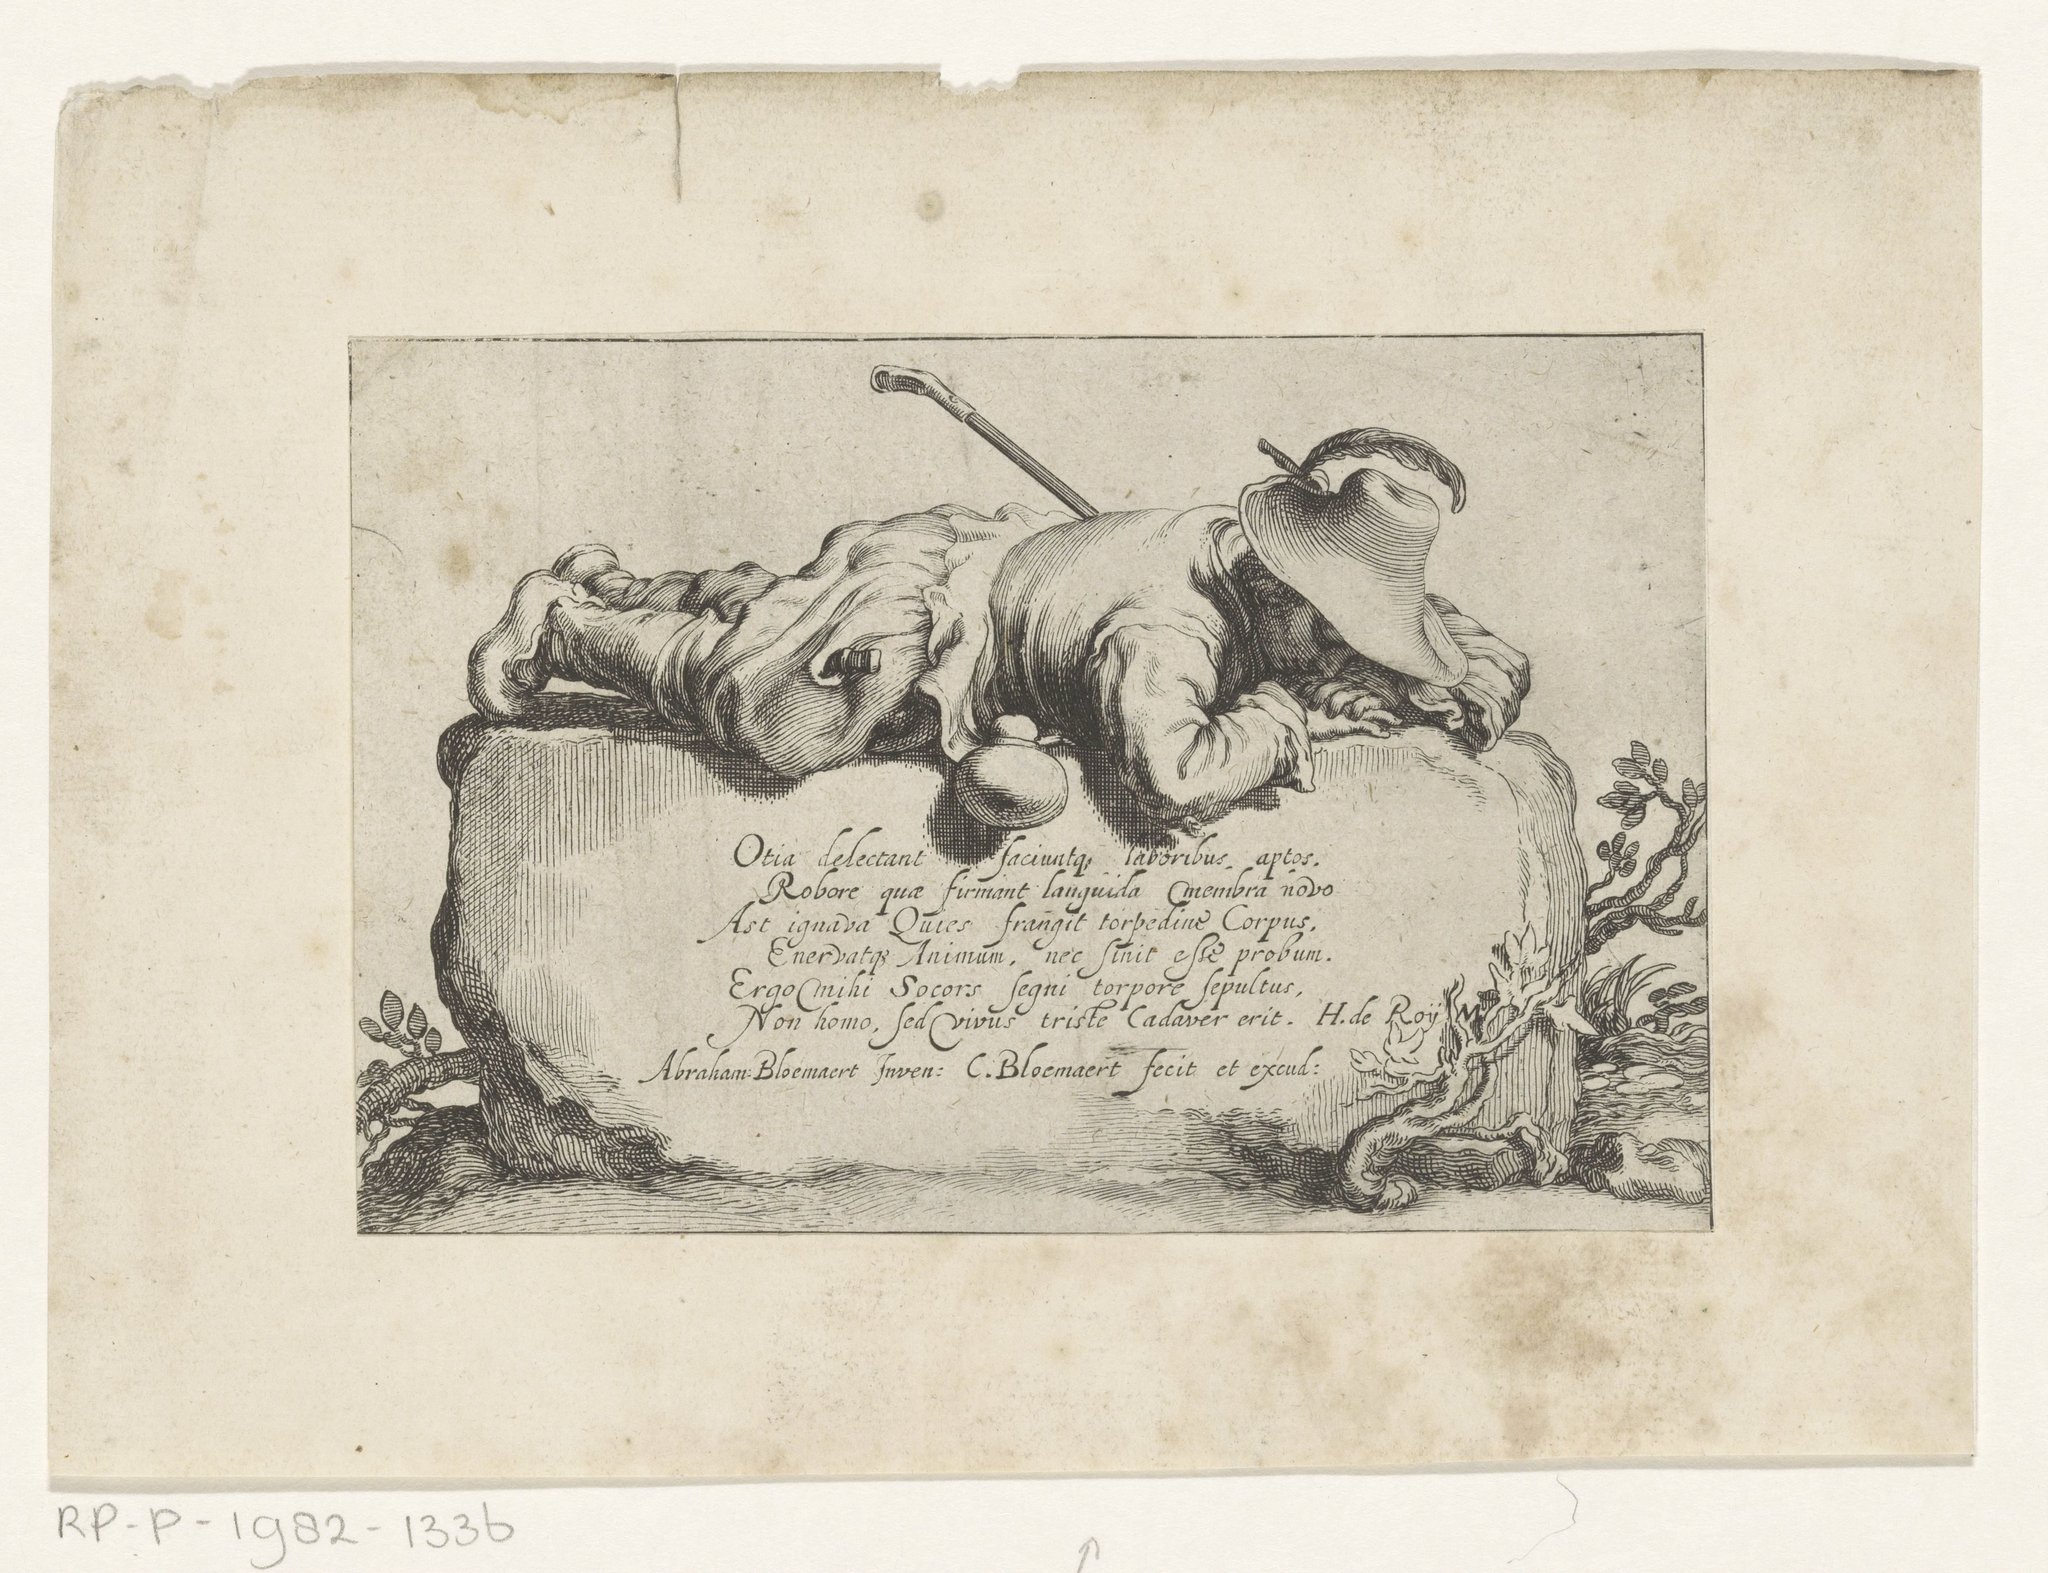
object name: titelprent, frontispice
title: Een herder ligt op een kei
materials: paper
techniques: etching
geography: utrecht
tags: herding, herdsman, herdswoman, shepherd, shepherdess, cowherd, etc., pastorals, arcadian scenes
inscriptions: collector's mark: Lugt 2760, collector's mark: Lugt 2228, stamp: ‘weenen vlahmsch[...] [...]schap / No’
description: Een man rust uit op een steen. Op de steen een zesregelig Latijns vers van Hendrik de Roij over luiheid en vrije tijd.